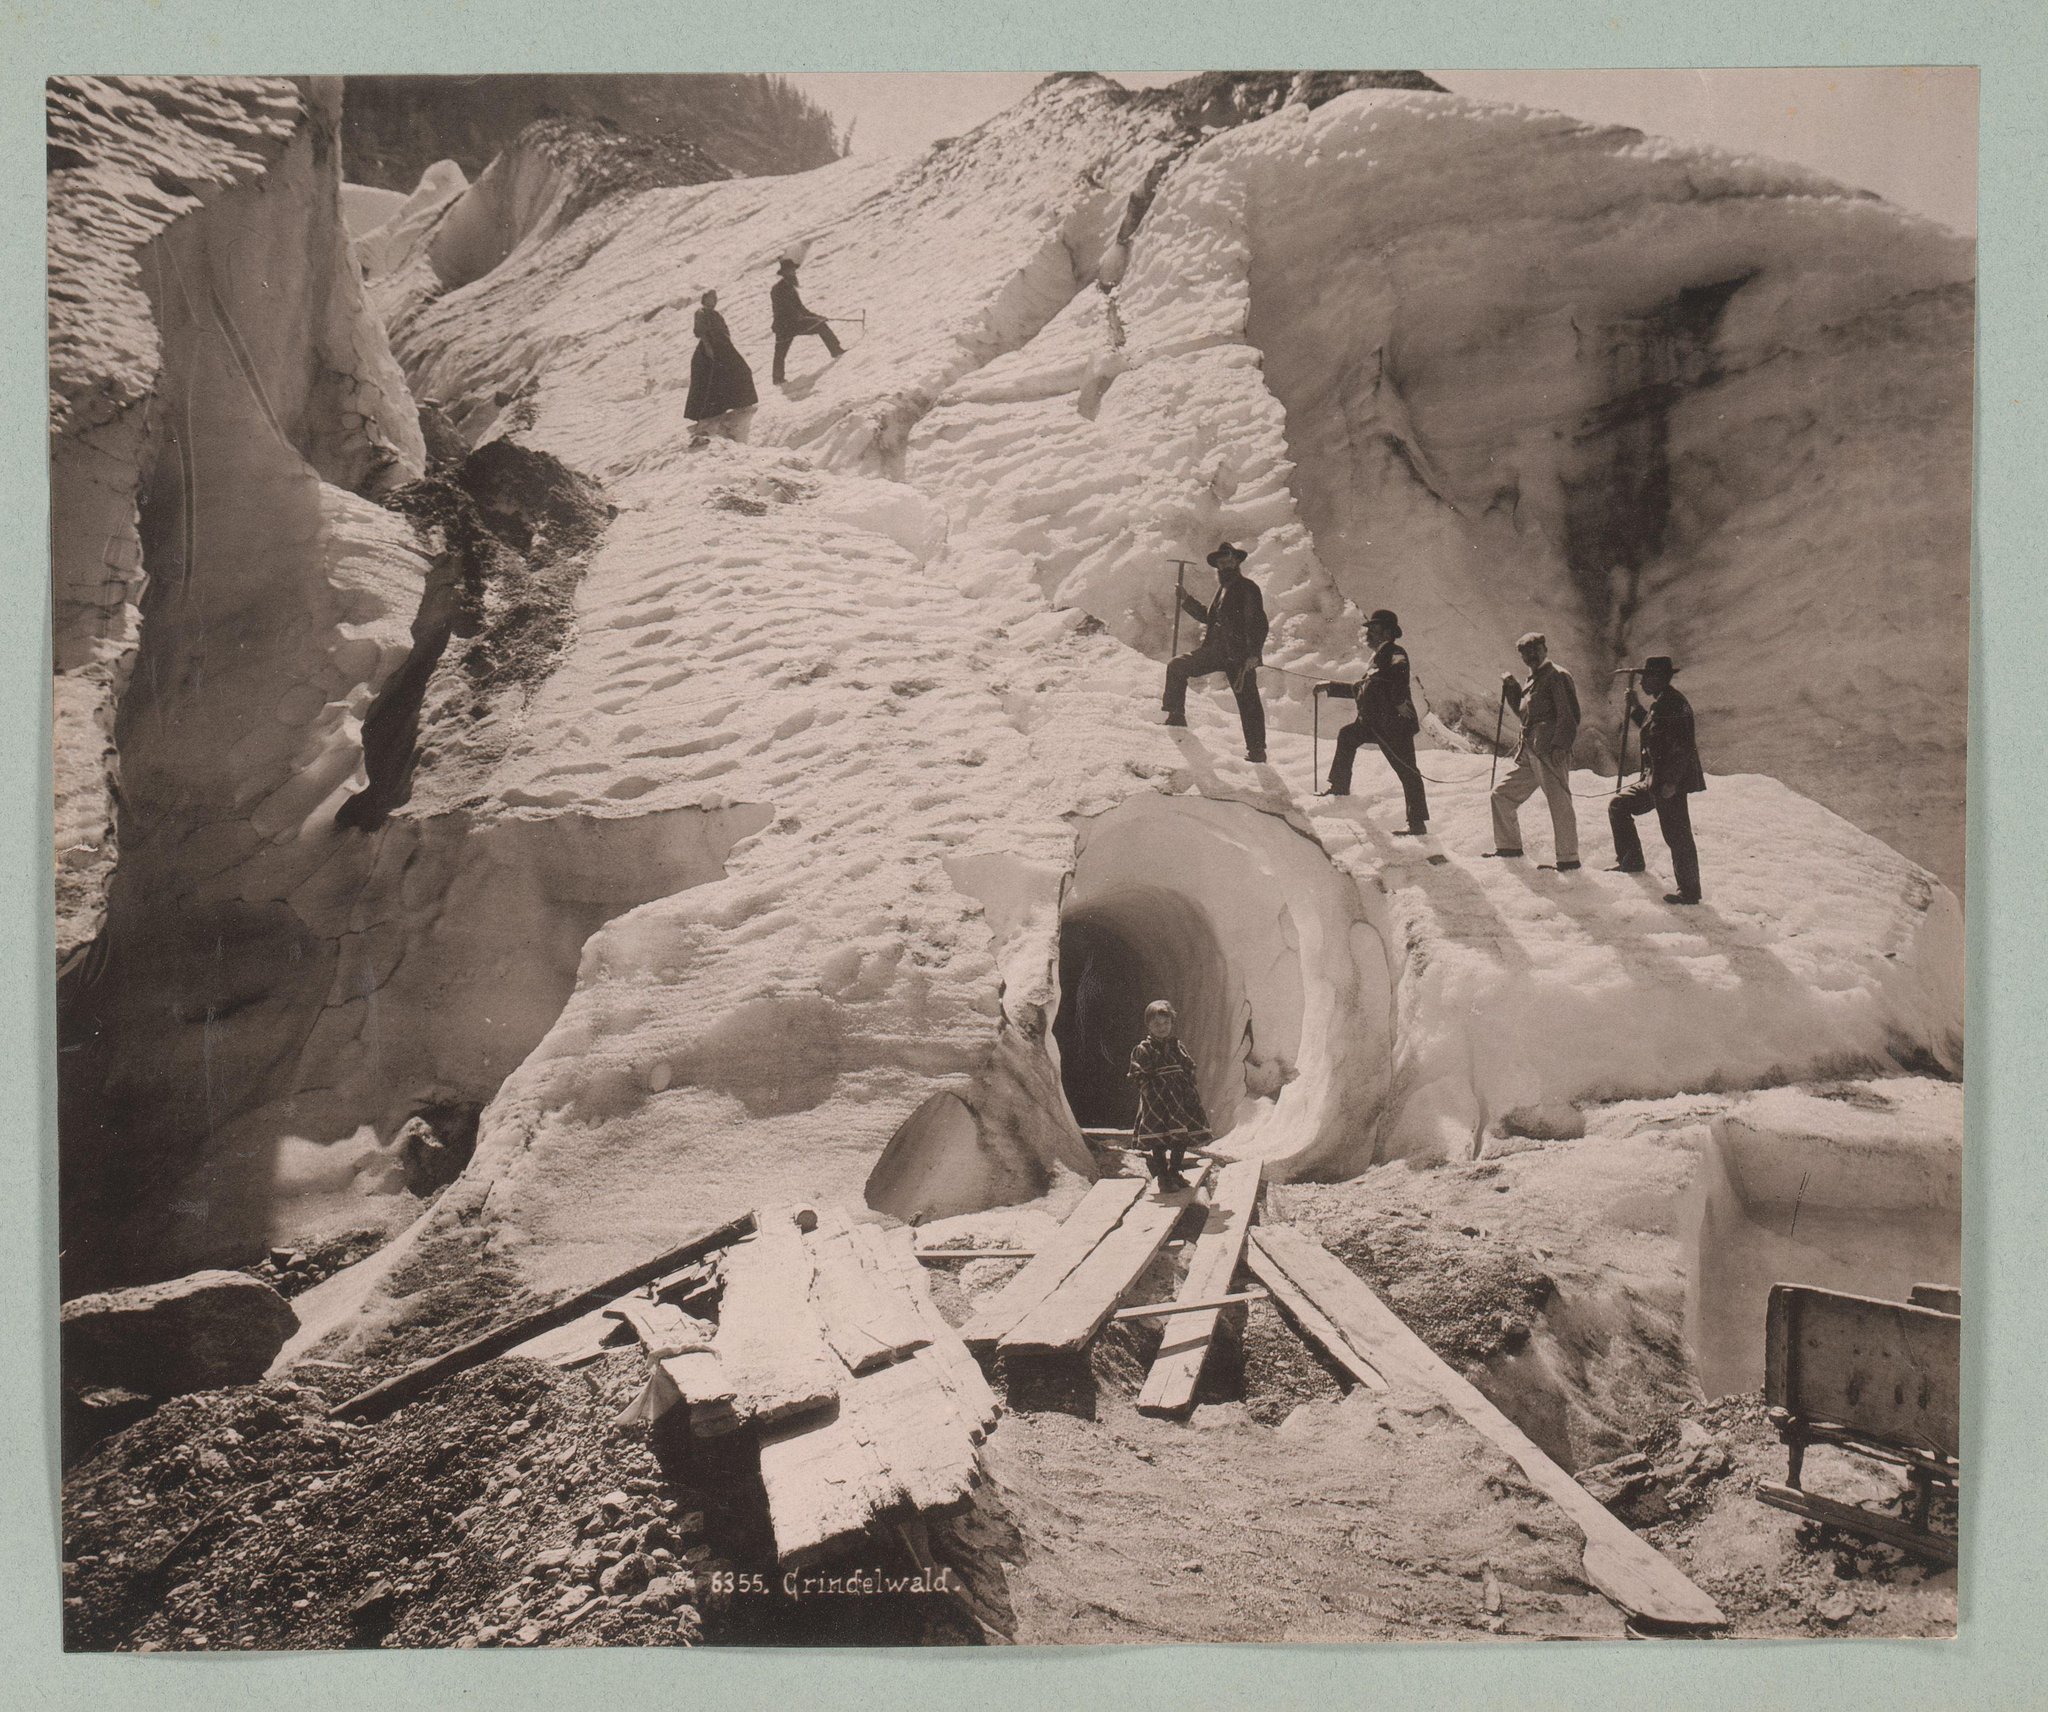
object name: photomechanical print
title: Grindelwald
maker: Anonymous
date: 1890-1910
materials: paper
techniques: photograph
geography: grindelwald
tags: mountain climbing, mountaineering, glacier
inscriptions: inscription: ‘6355. Grindelwald.’